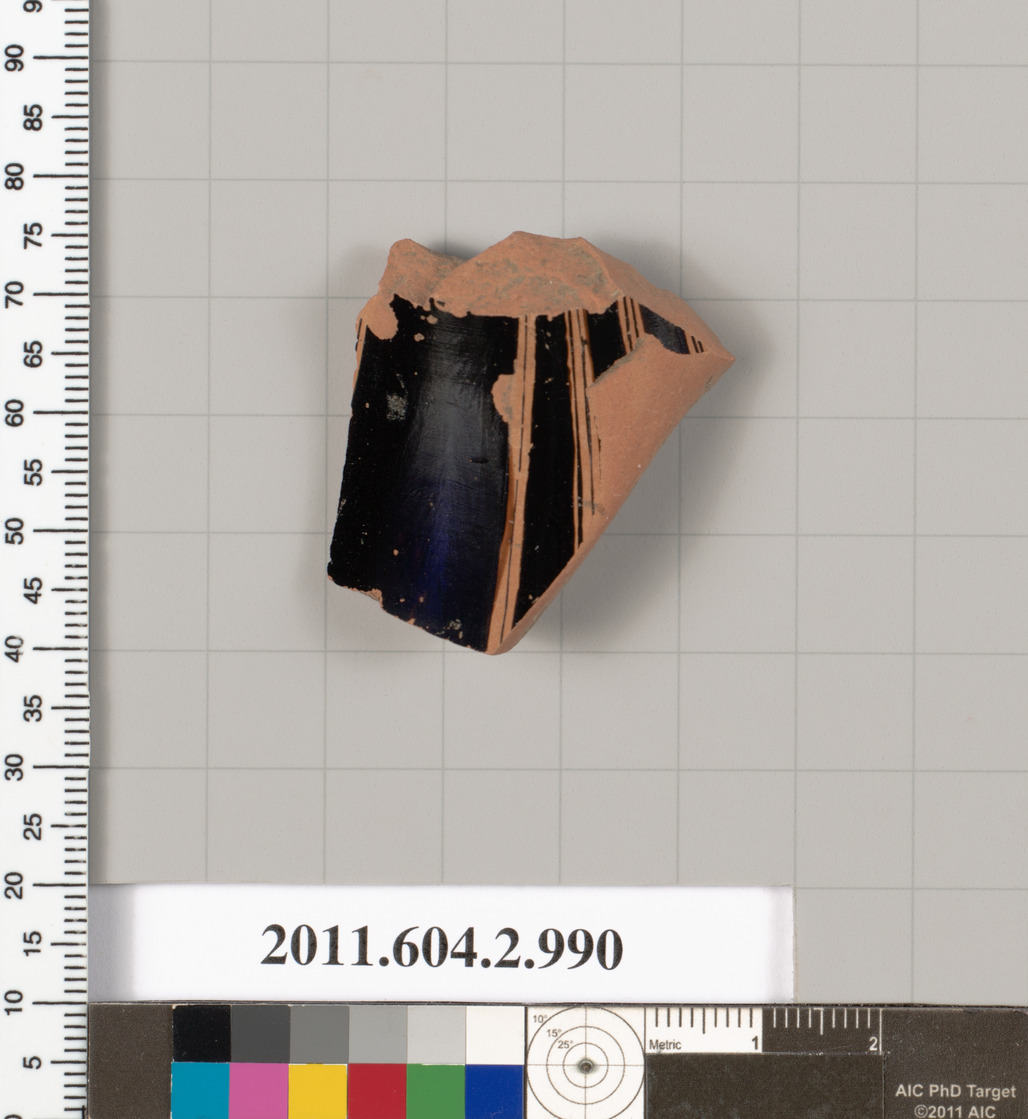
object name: oinochoe fragment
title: Terracotta fragment of an oinochoe (jug)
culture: greek, attic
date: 475-451 BCE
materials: terracotta